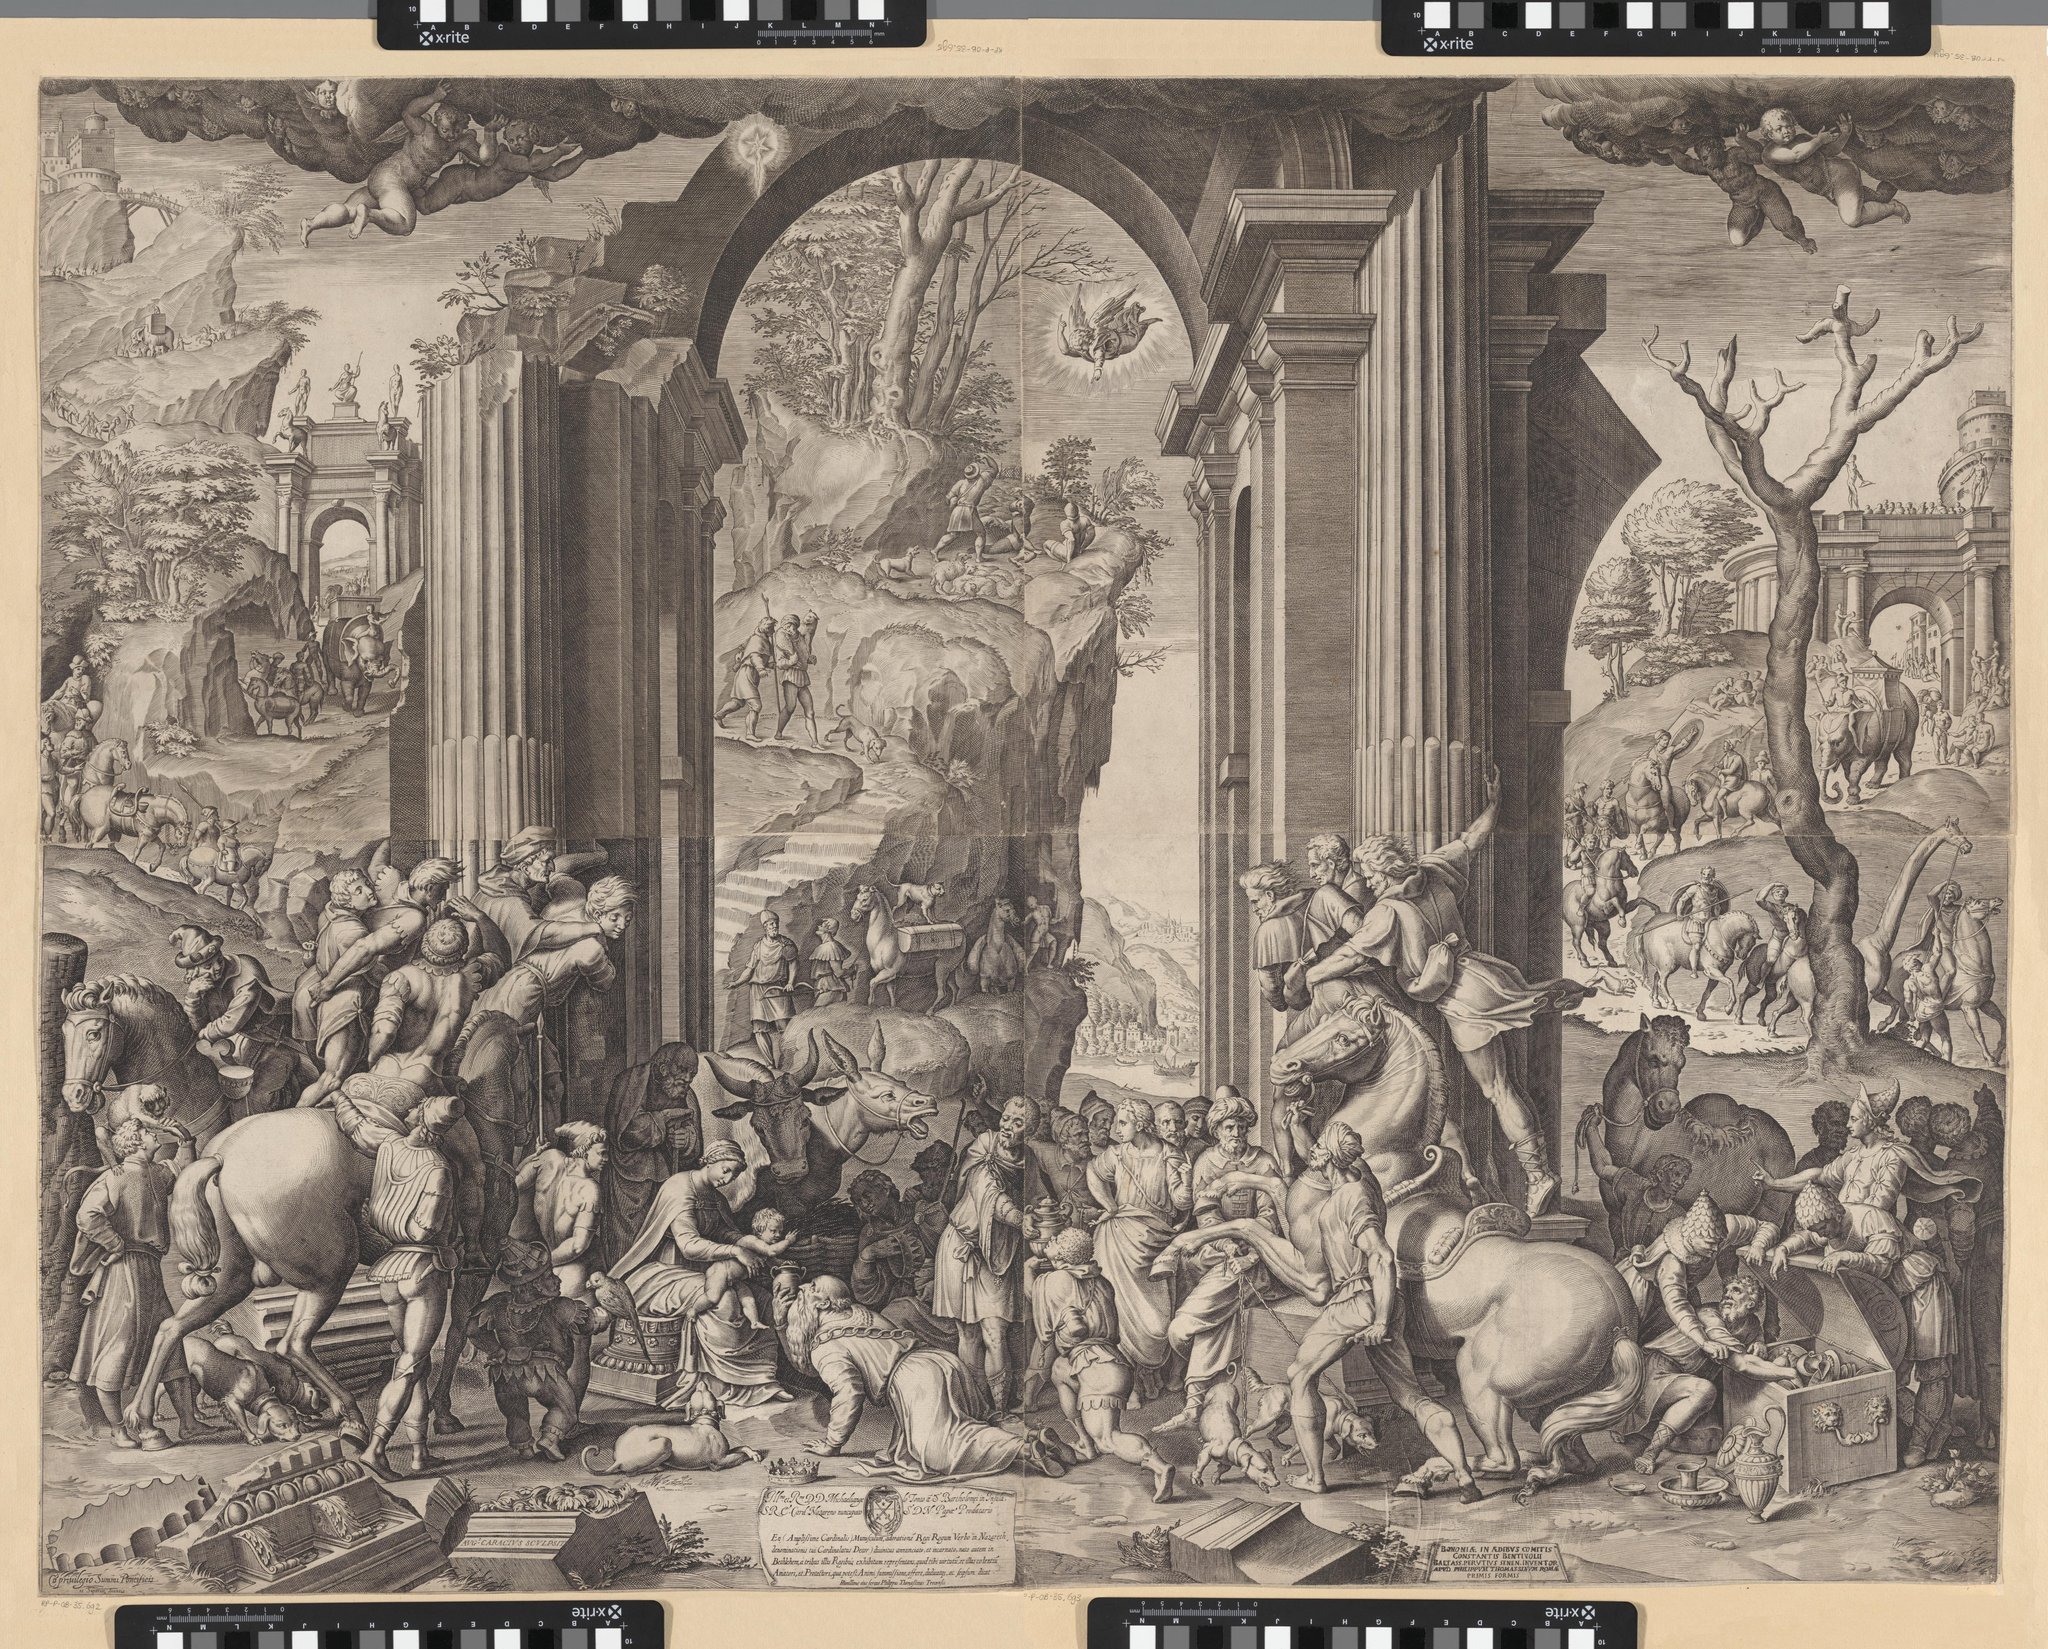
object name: print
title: Aanbidding door de koningen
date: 1567-1602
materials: paper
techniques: engraving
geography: bologna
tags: adoration of the kings: the wise men present their gifts to the christ-child (gold, frankincense and myrrh)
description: De aanbidding van het Christuskind door de koningen voor een grote ruïne. Op de achtergrond een heuvellandschap met antieke bouwwerken en de processie met het gevolg van de koningen. Boven de ruïne verschijnt God de Vader vergezelt door een koor van engelen.